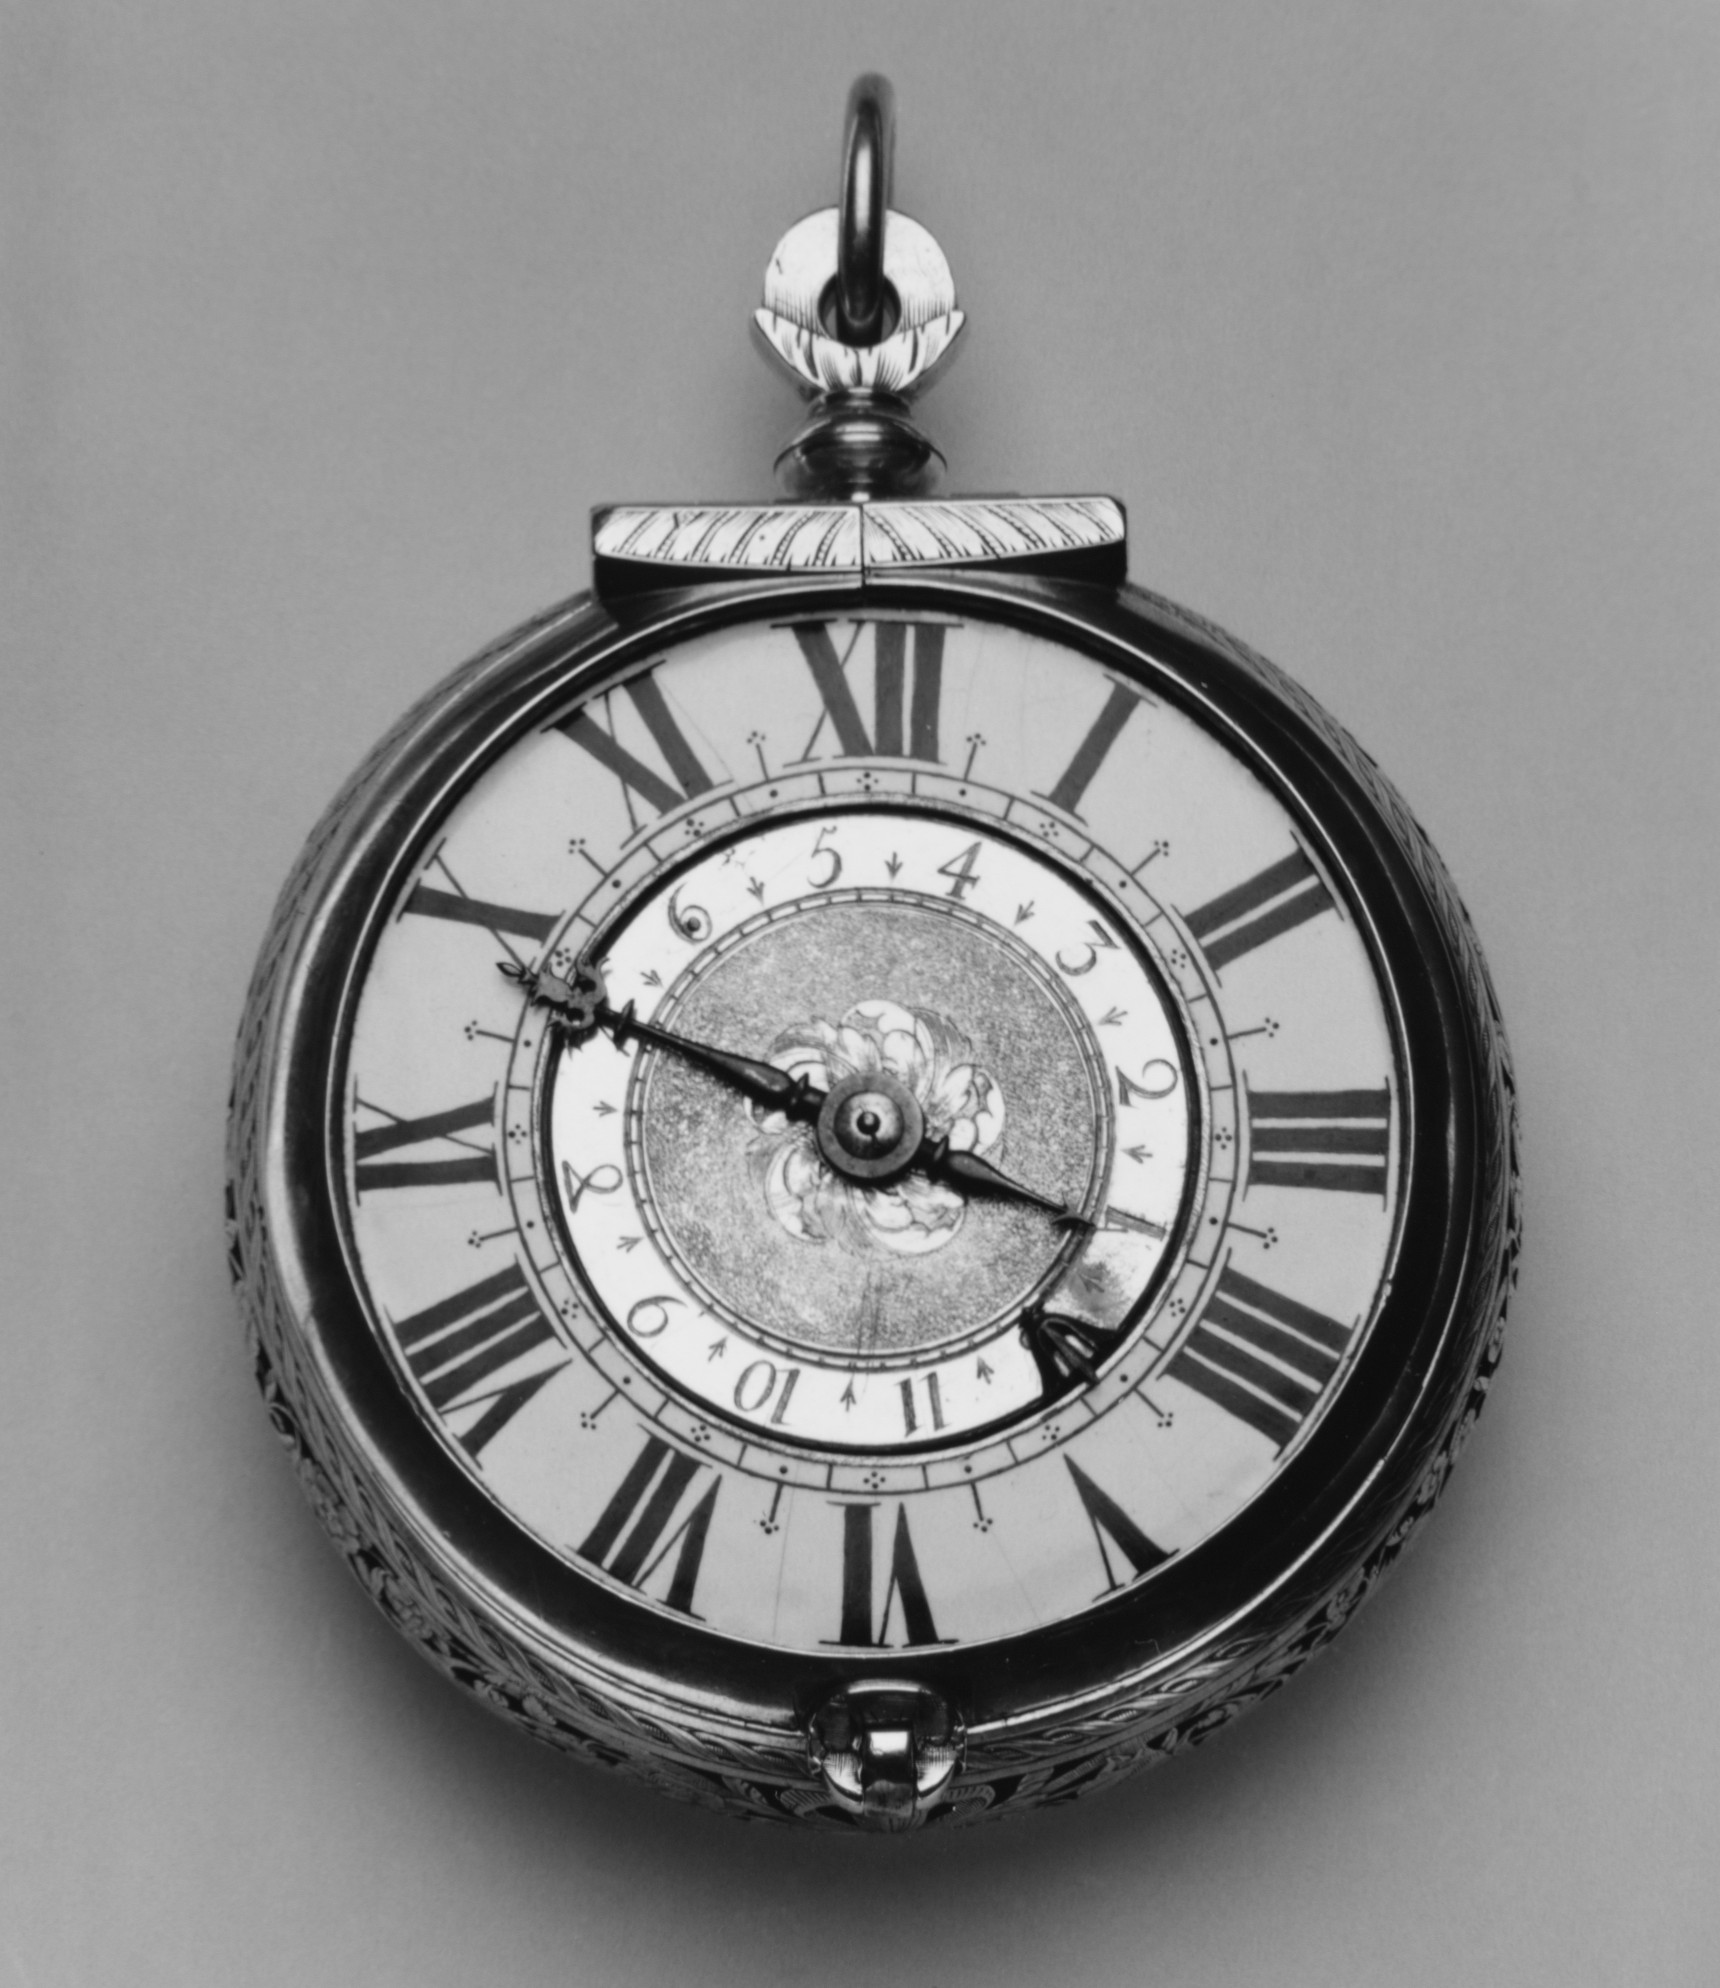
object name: watch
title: Traveling watch with alarm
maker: auguste bretoneau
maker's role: maker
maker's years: 1638-1643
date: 1650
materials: enamel, gilt, silver